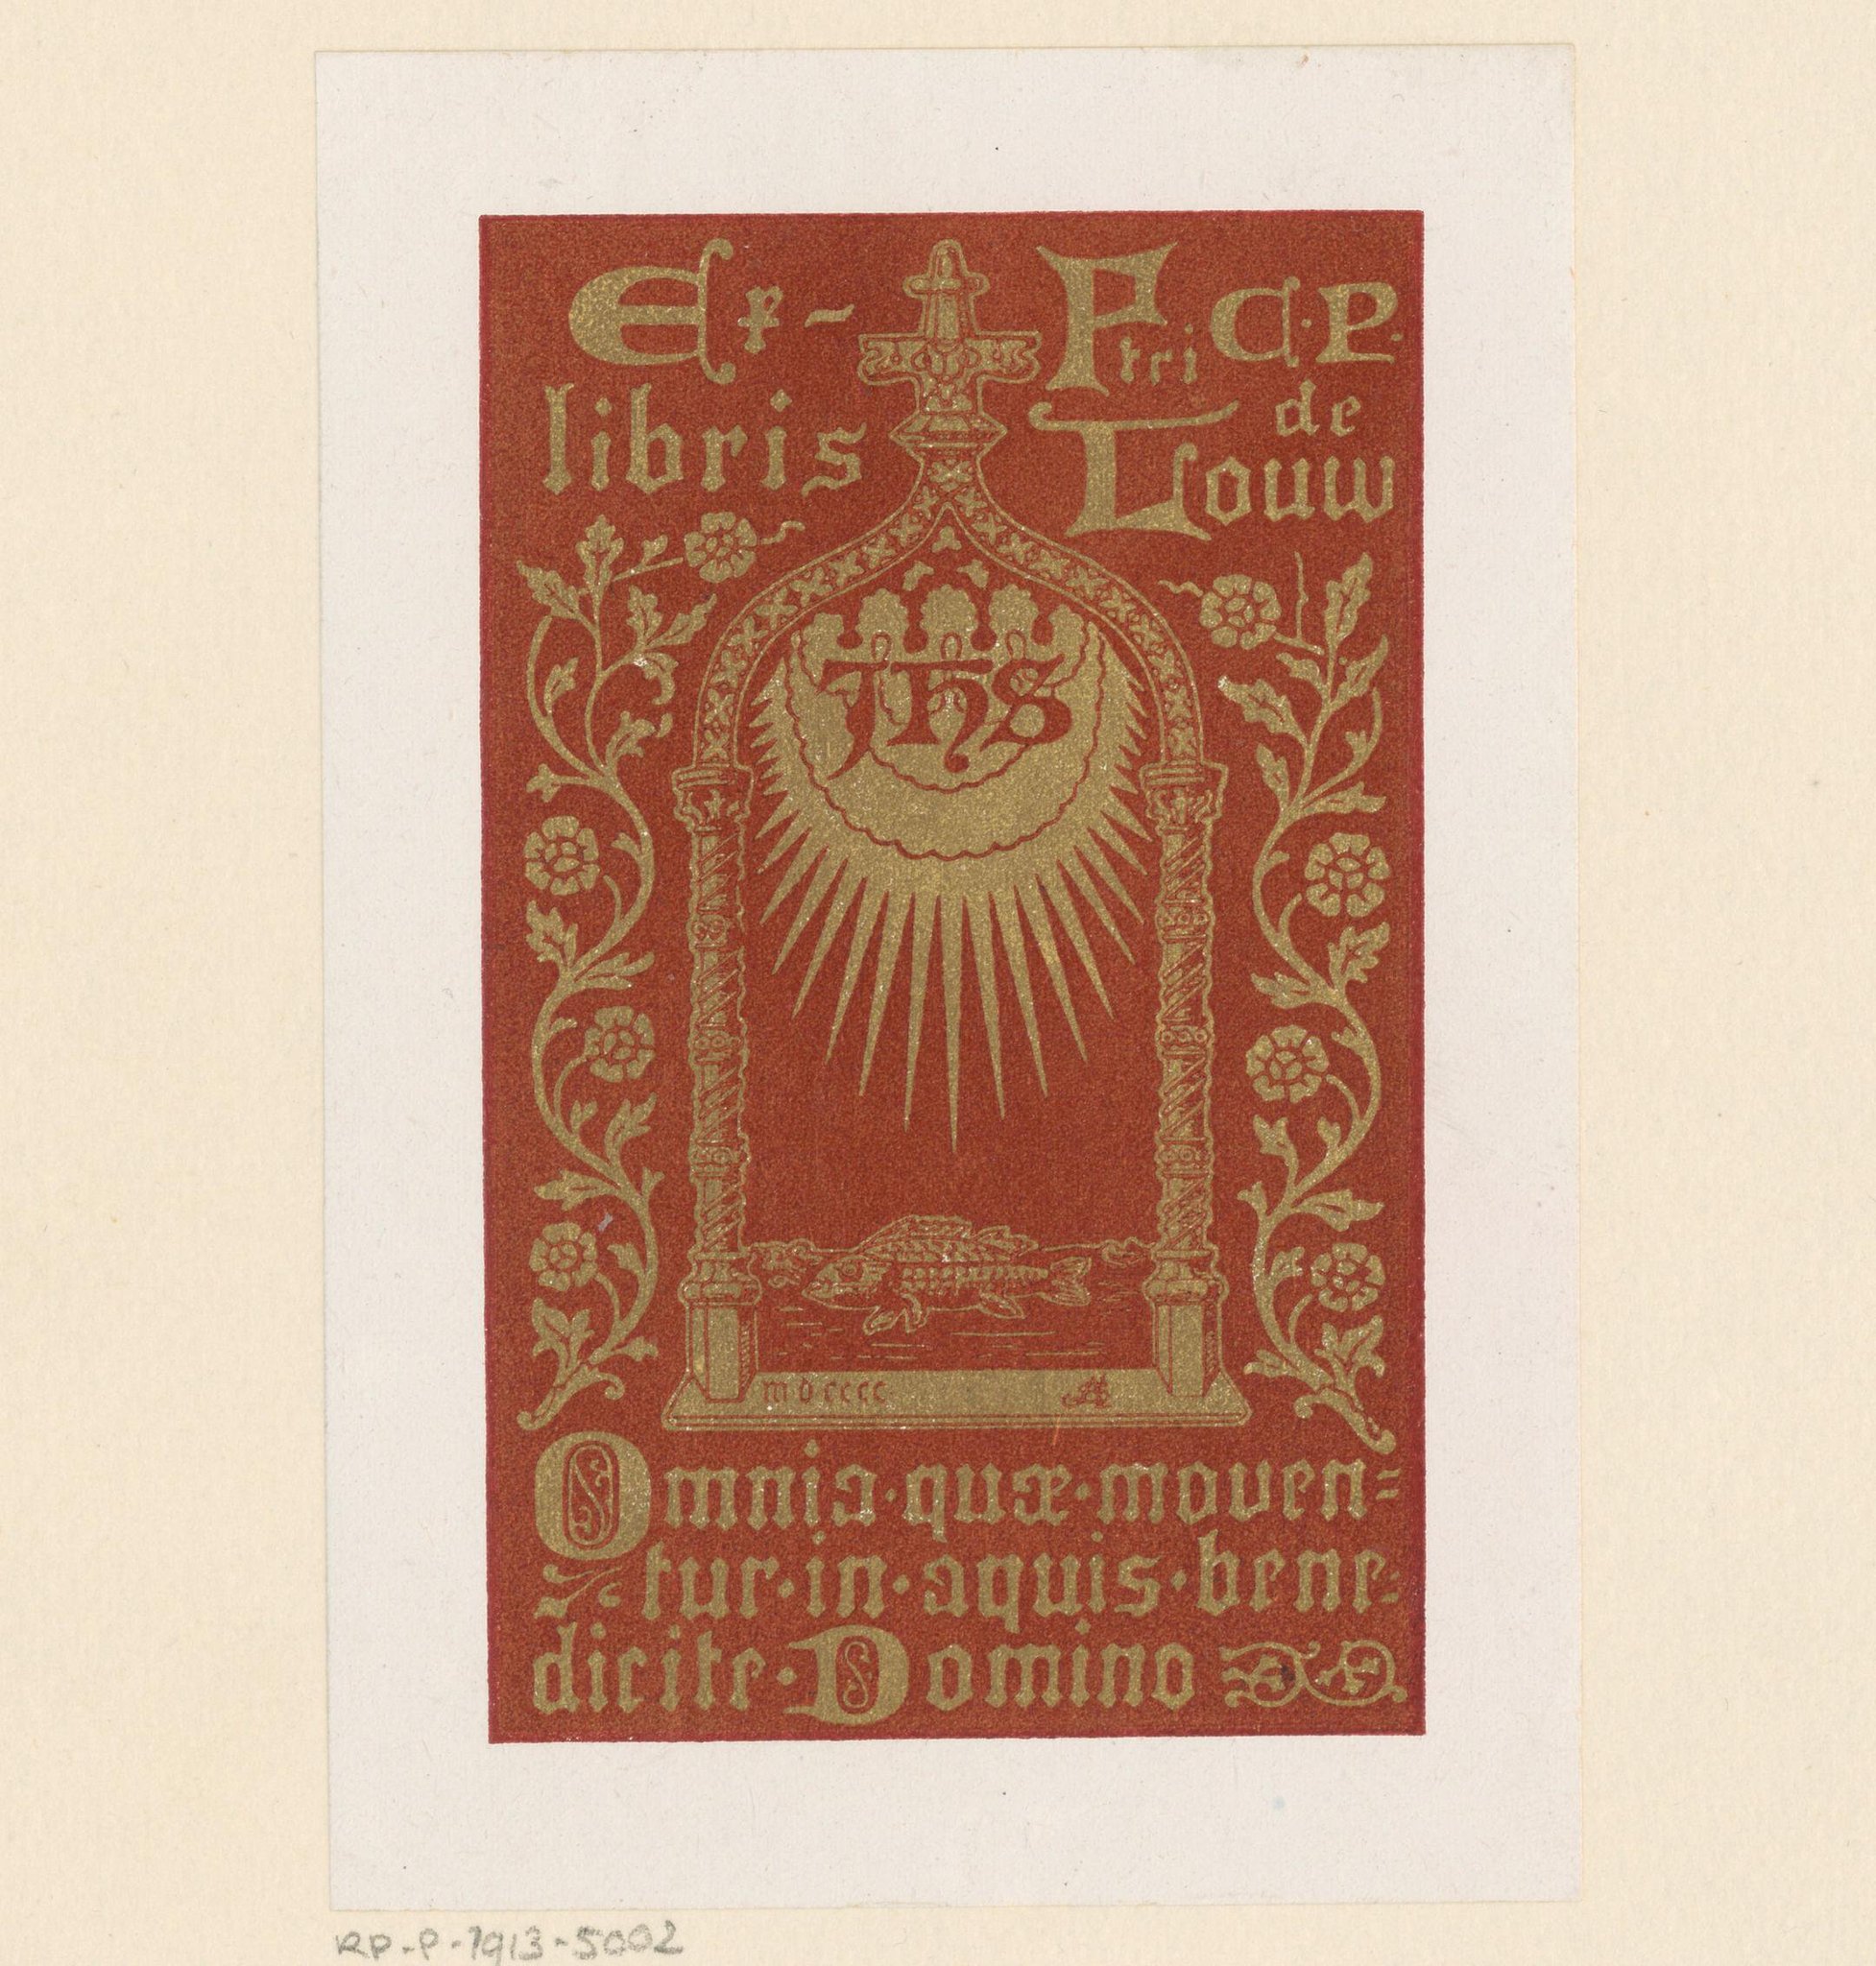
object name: bookplate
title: Ex libris van P.C.P. de Louw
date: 1900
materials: paper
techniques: printing block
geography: netherlands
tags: ihs ('iesus hominum salvator') ~ symbol of christ, fishes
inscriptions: collector's mark: Lugt 2233, collector's mark: Lugt 2760